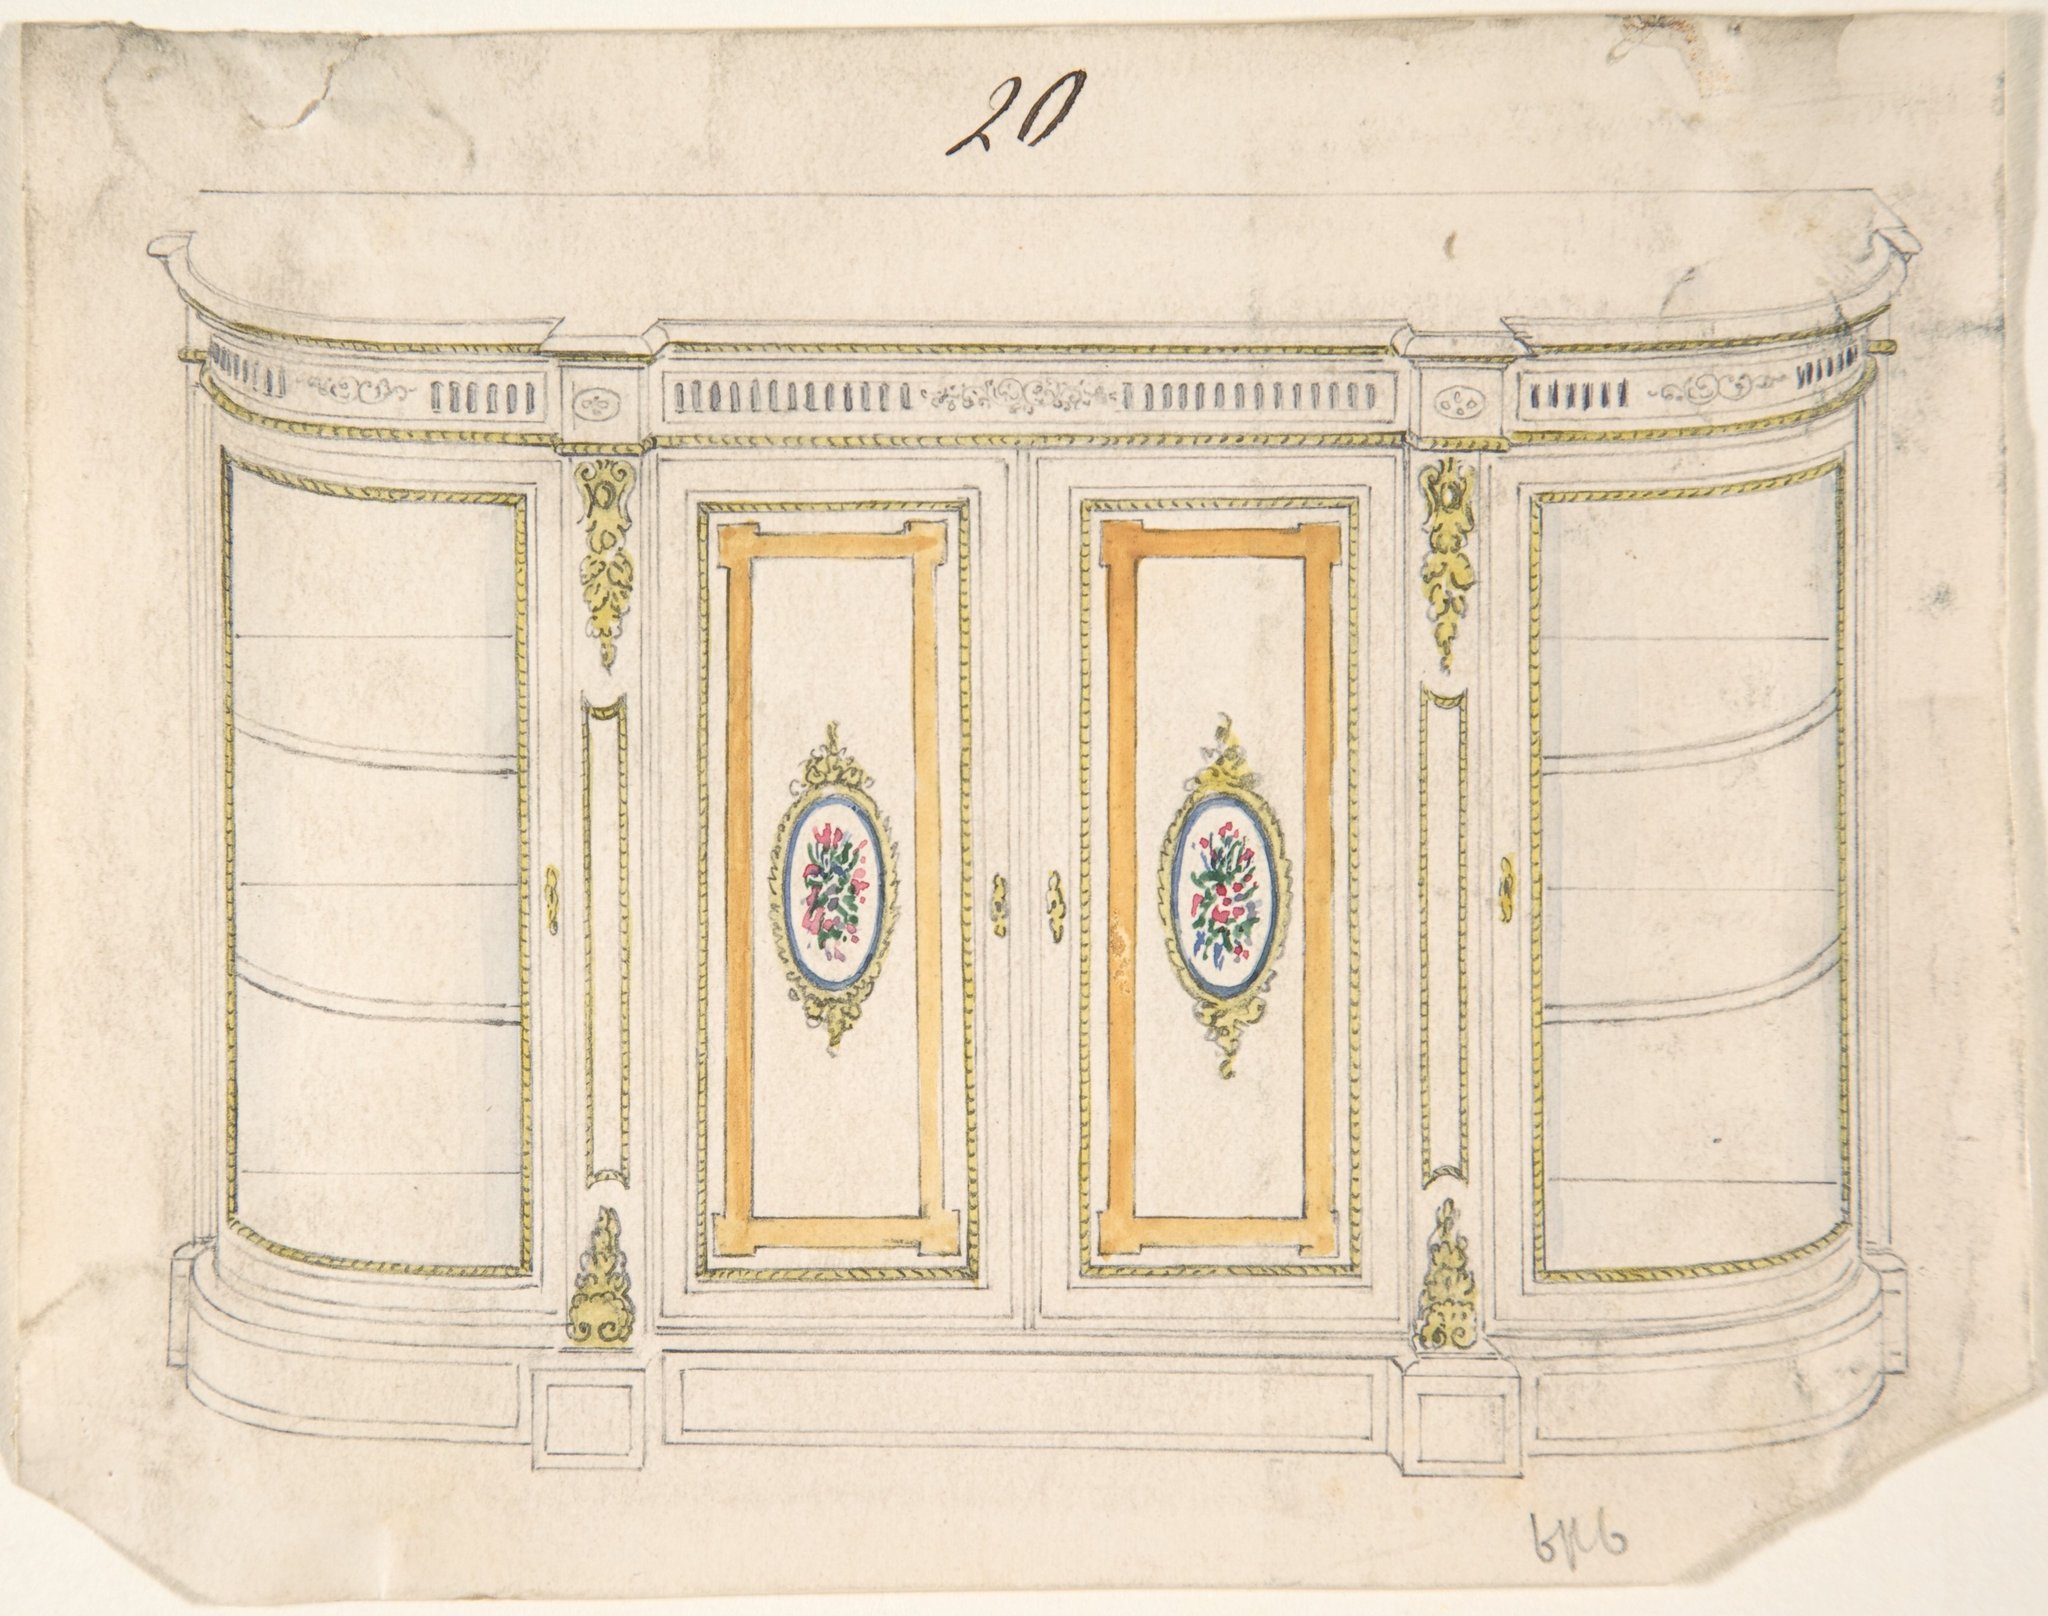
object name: drawing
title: Cabinet Design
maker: anonymous, british, 19th century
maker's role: artist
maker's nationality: british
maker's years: 1800-1900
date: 1801-1900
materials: ink, watercolor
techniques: pen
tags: cabinets